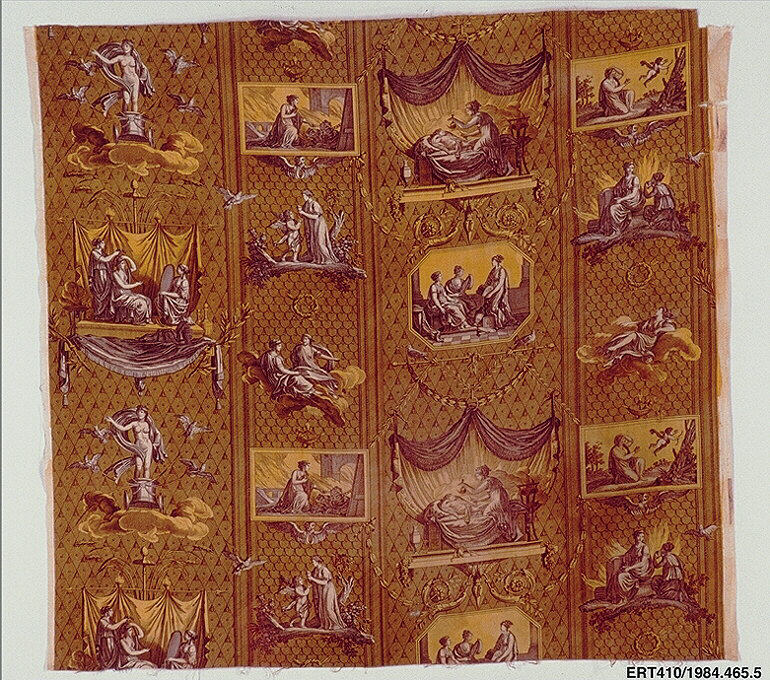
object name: piece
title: Cupid and Psyche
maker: jean-baptiste huet i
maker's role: designer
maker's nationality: french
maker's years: 1745-1811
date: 1810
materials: cotton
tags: birds,cupid,psyche